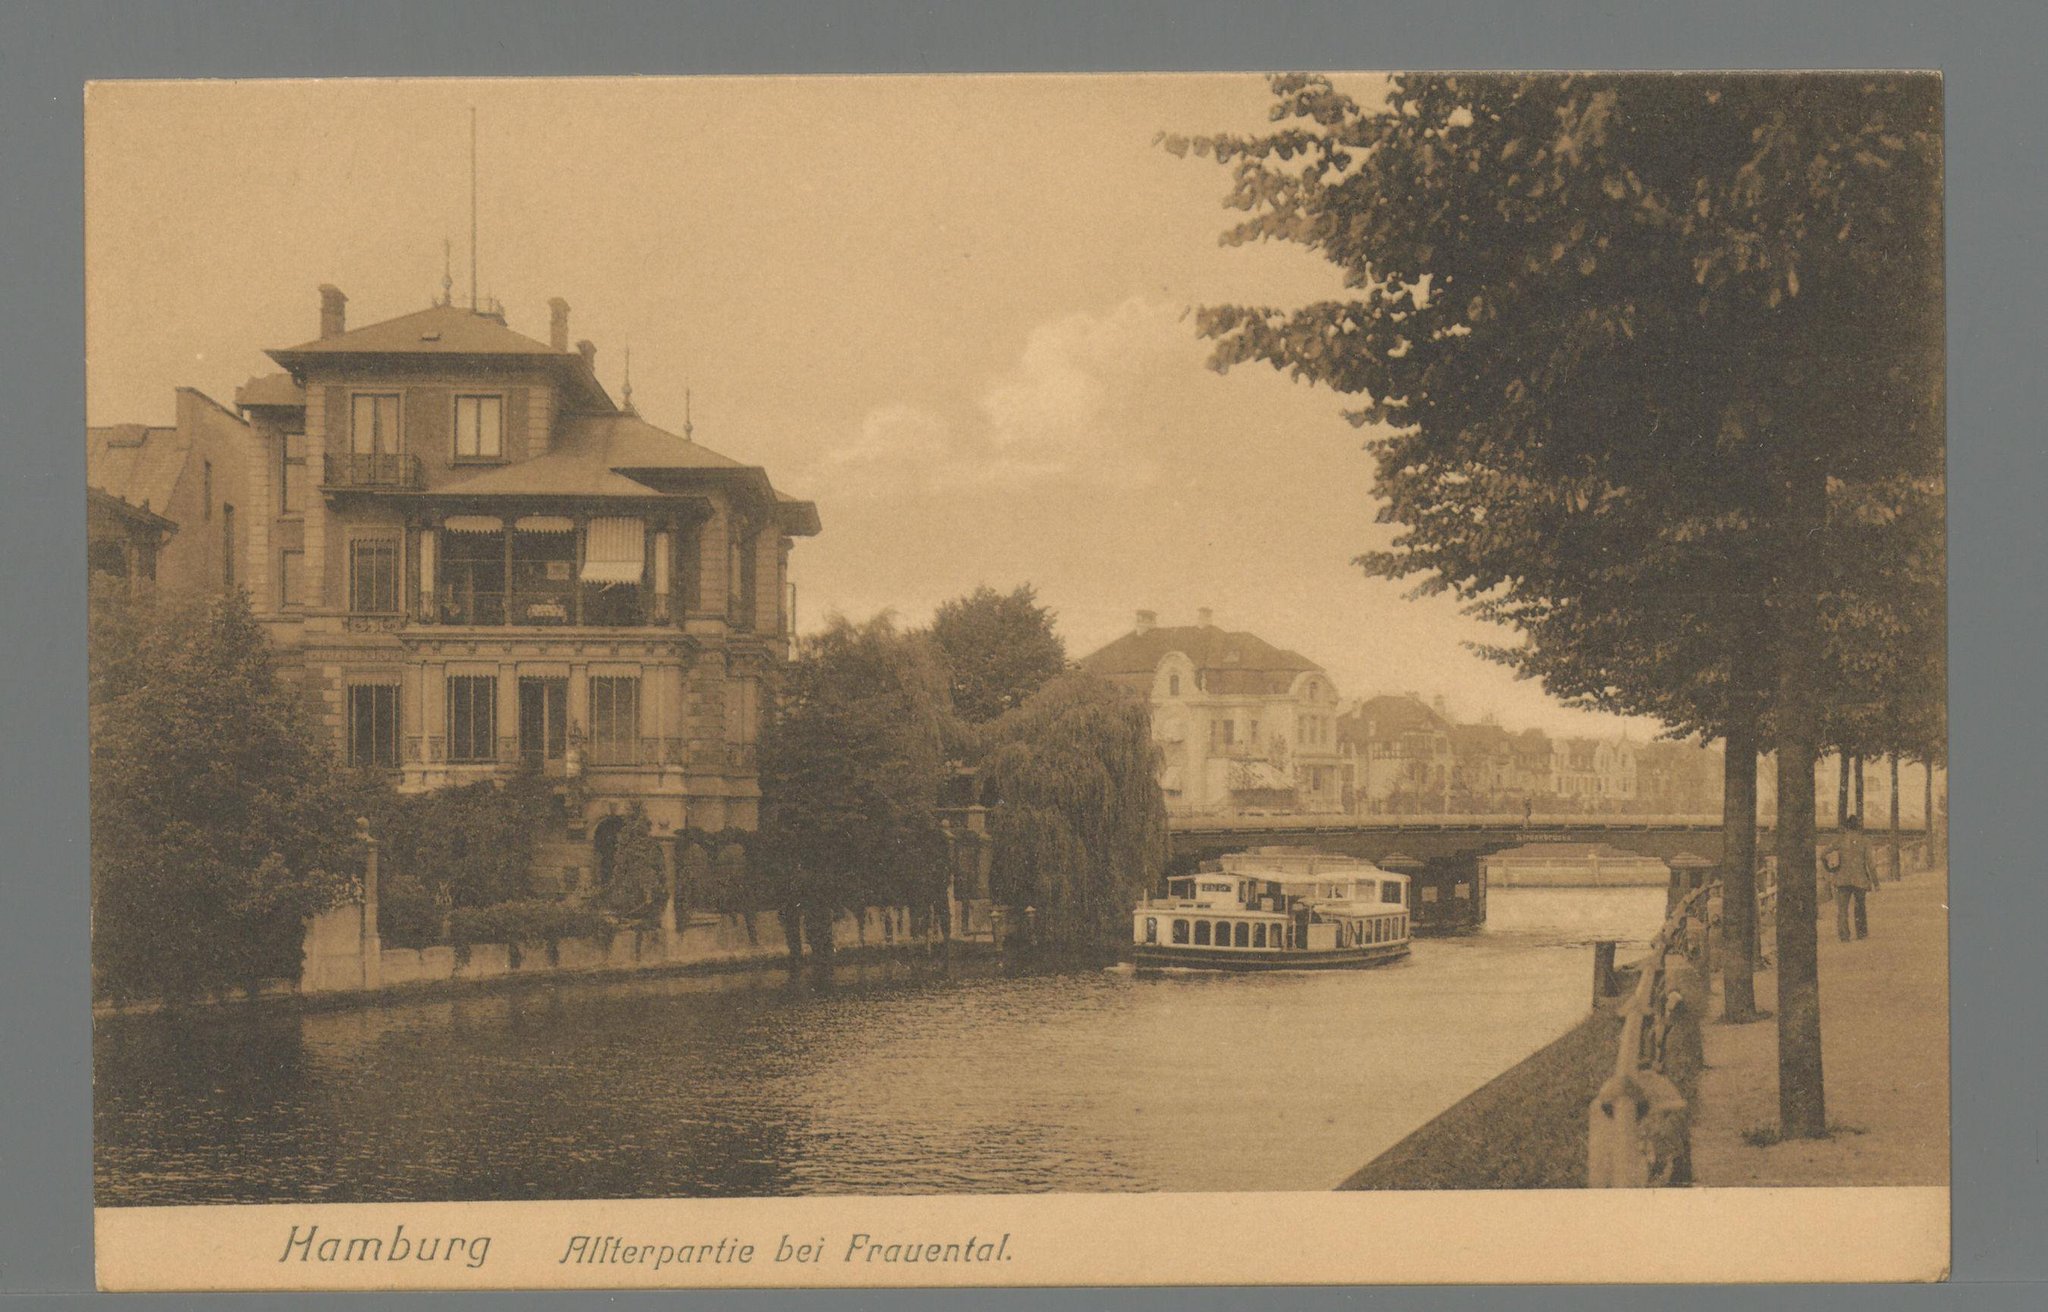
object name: ansichtkaart, prentbriefkaart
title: Luxusdruck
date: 1905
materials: cardboard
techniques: photograph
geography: hamburg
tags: ferry, canals, waters (in city), bridge in city across river, canal, etc.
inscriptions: date